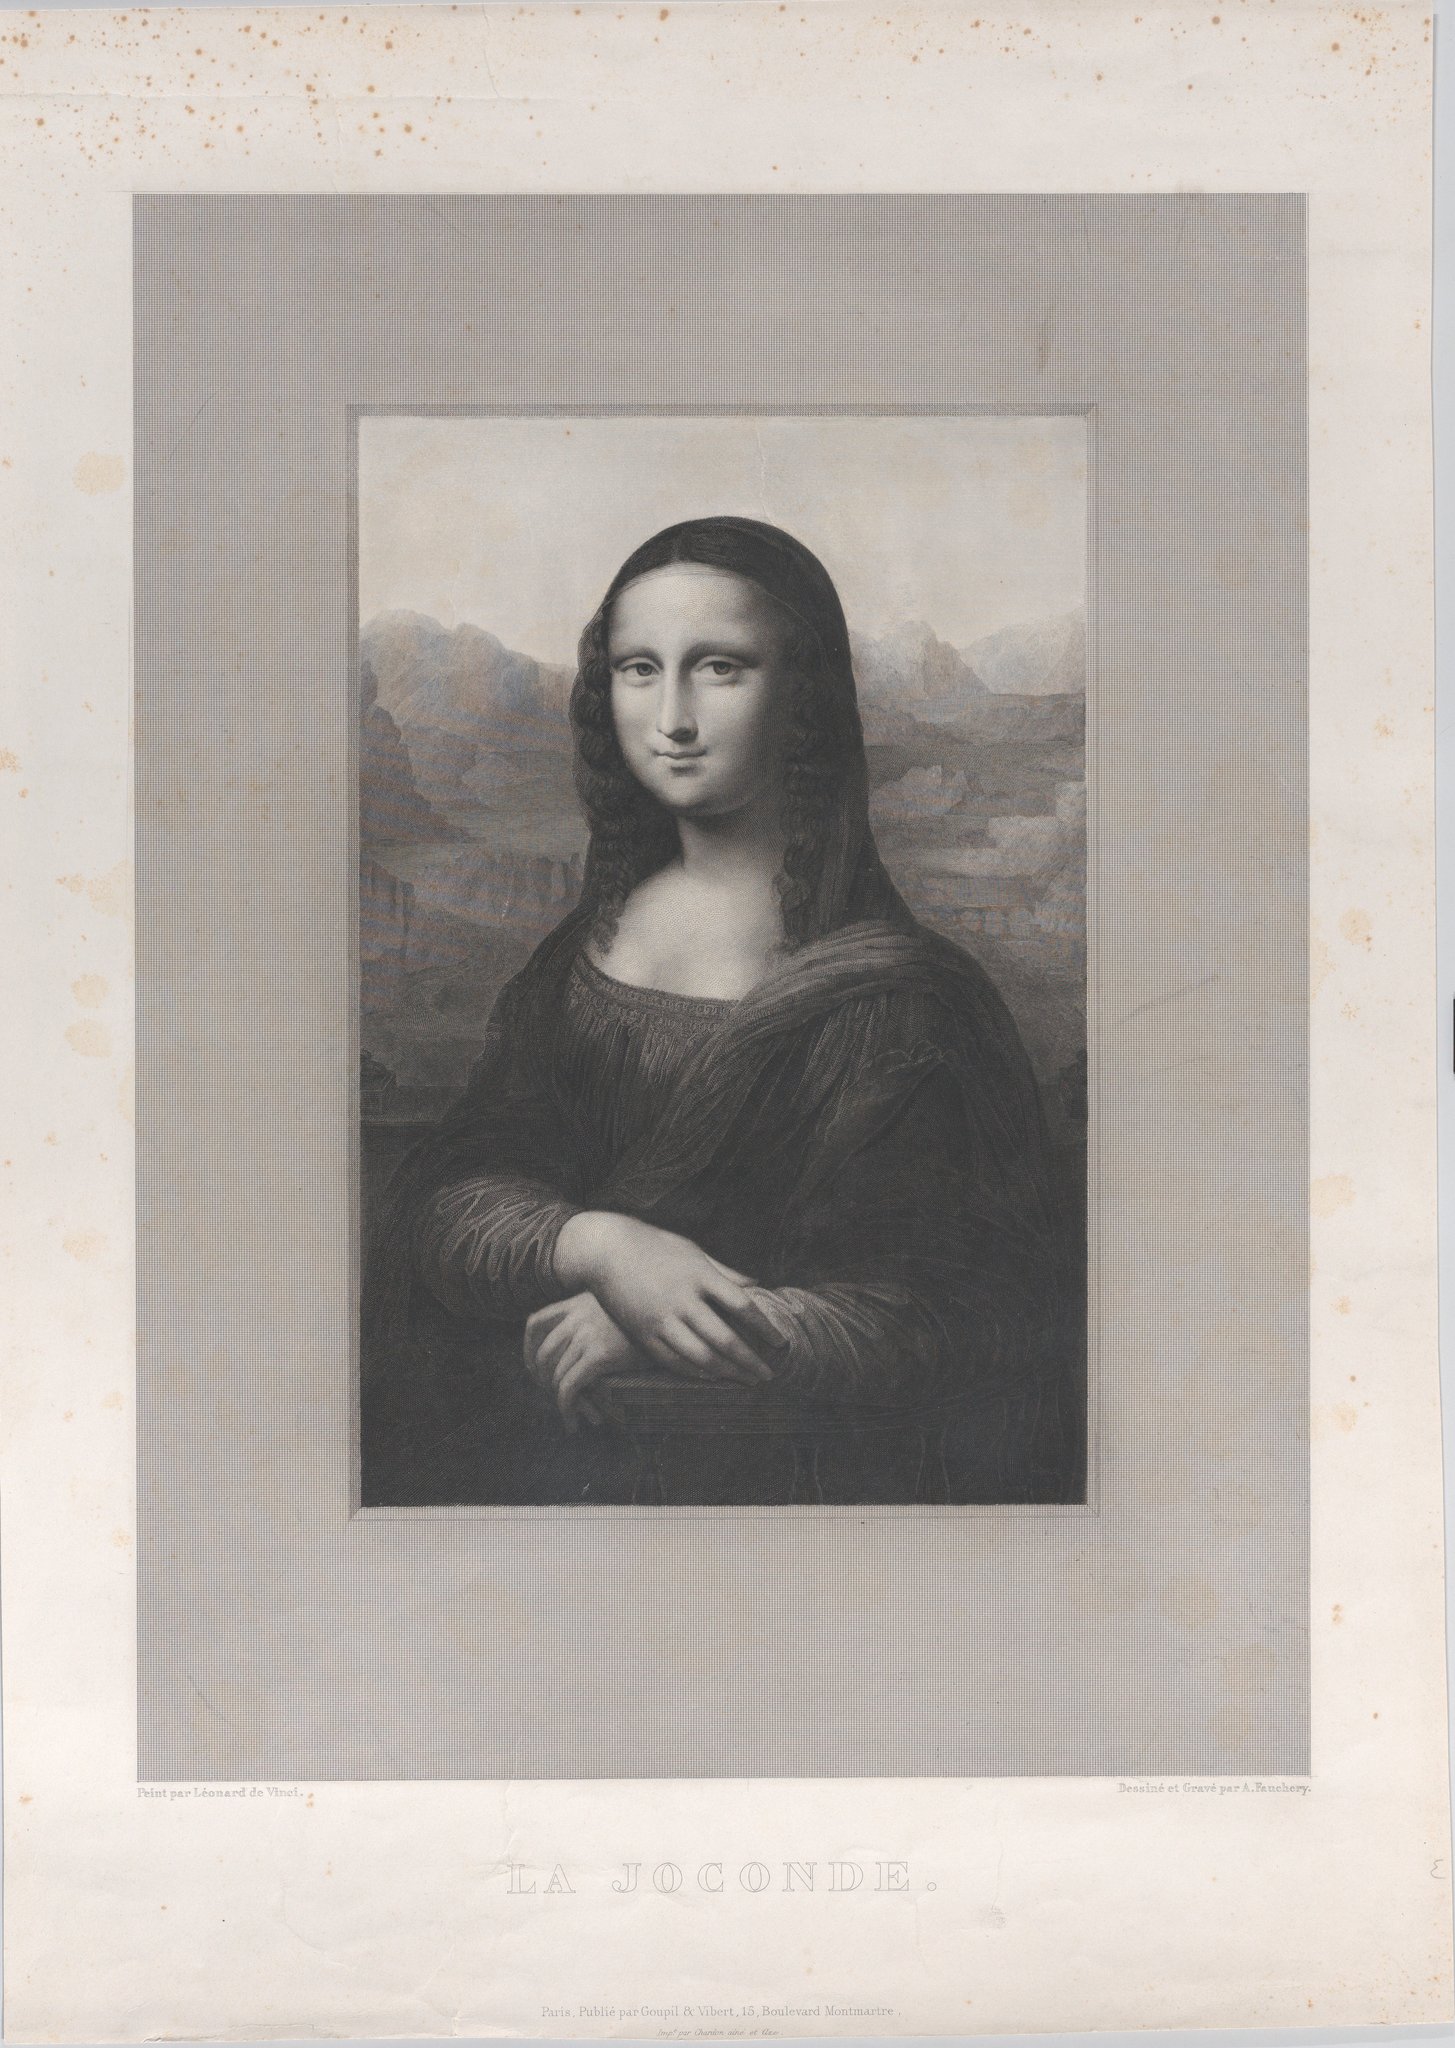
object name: print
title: Mona Lisa (La Joconde)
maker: augustine fauchery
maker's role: artist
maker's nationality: french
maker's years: 1803-1903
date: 1820-1860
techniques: engraving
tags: portraits,women